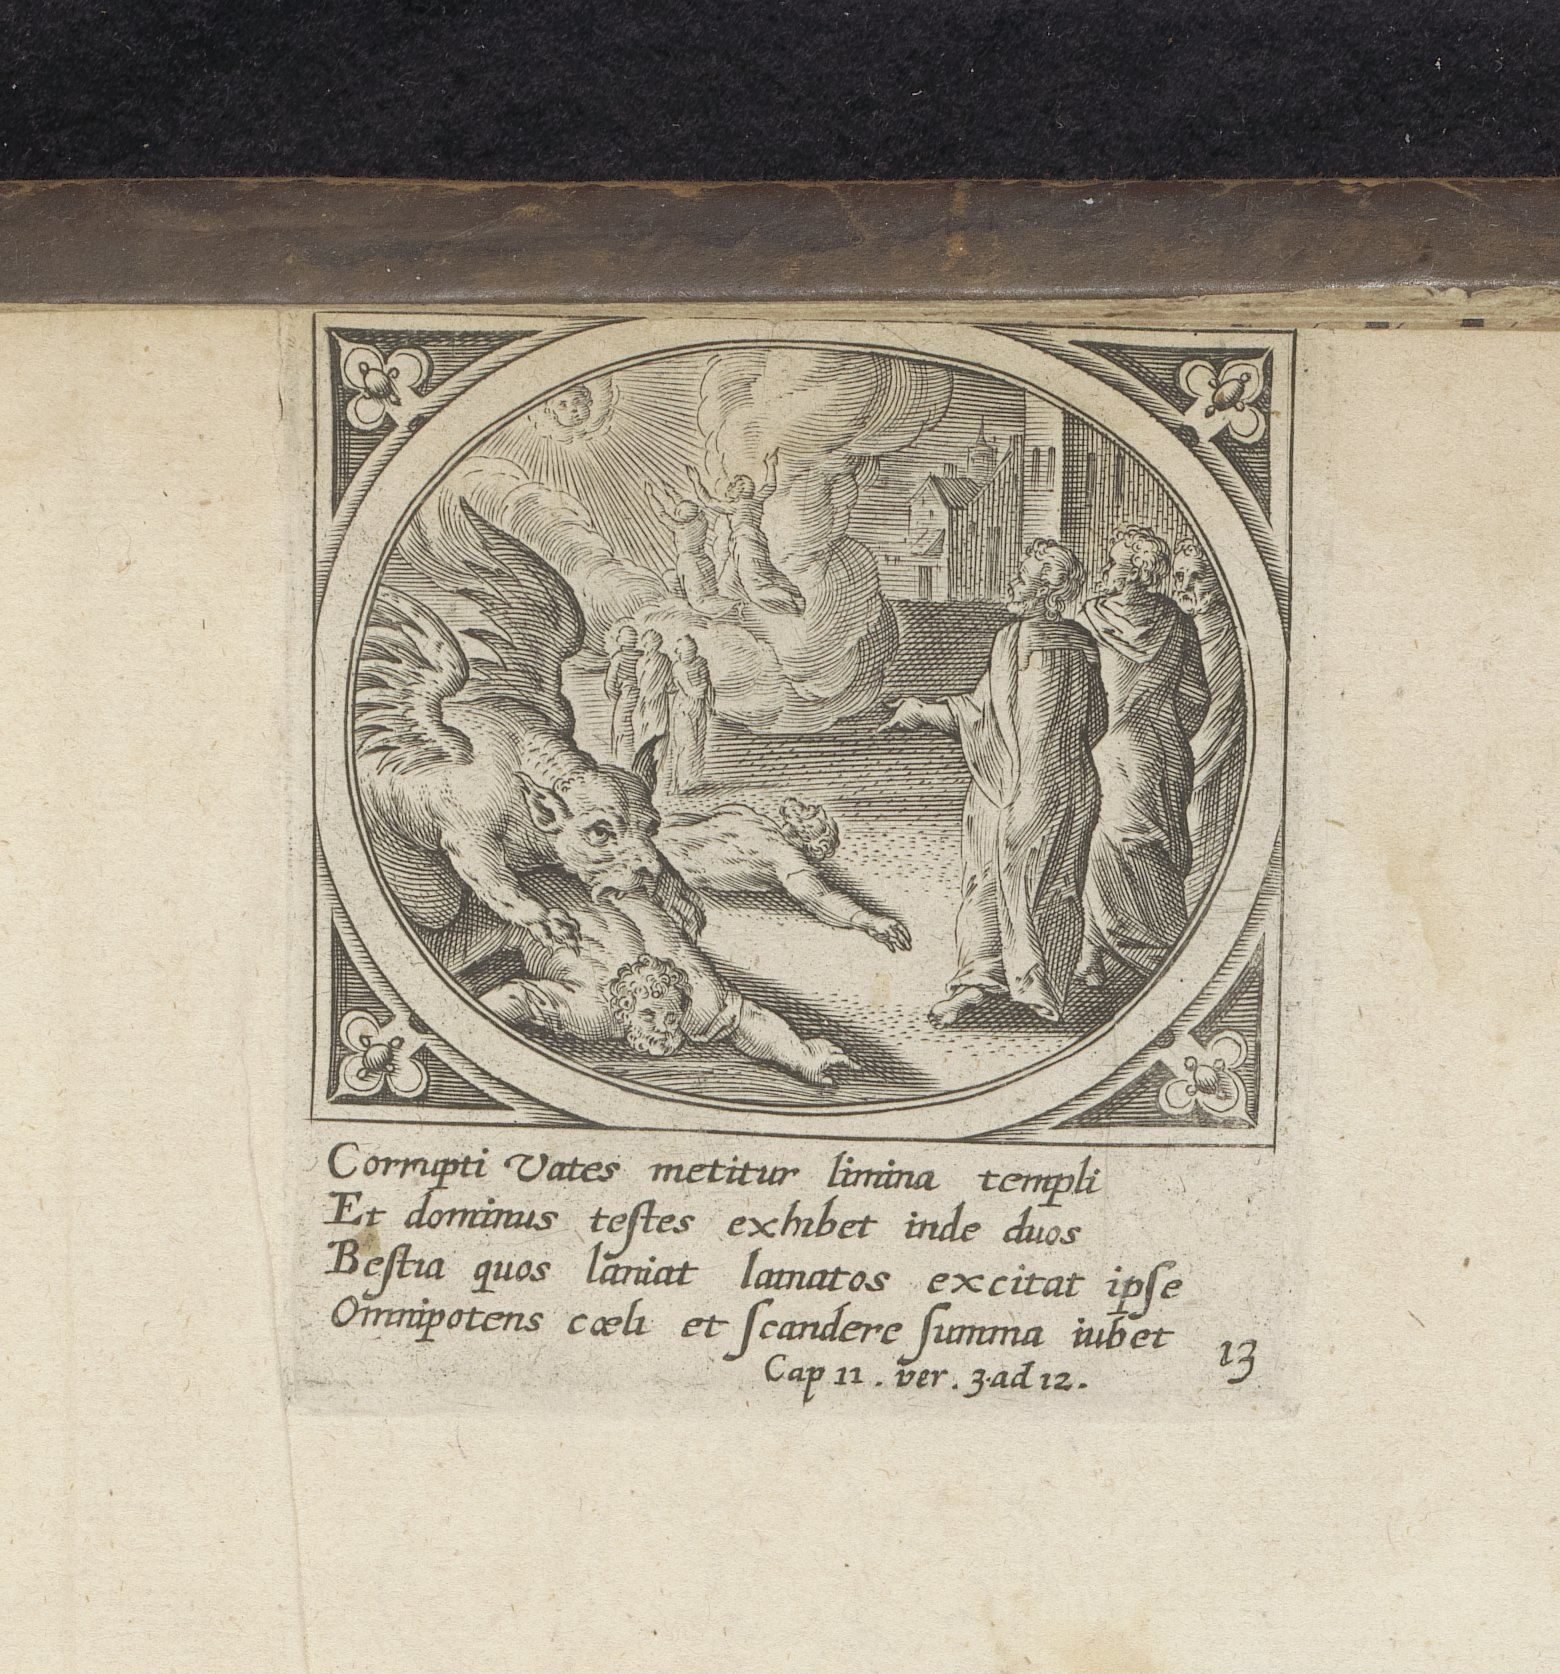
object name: print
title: Icones Revelationum S Iohs Evangeliste in Pathmo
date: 1585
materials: paper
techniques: engraving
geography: amsterdam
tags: the two witnesses of god are slain by the beast and the people rejoice over their death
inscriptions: number: ‘2[1]0’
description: De twee getuigen profeteren en worden gedood door het beest uit de onderaardse diepte. Op de achtergrond stijgen zij ten hemel. Onder de voorstelling een verwijzing in het Latijn naar de Bijbeltekst in Op. 11:3-12. Deze prent maakt deel uit van een album.